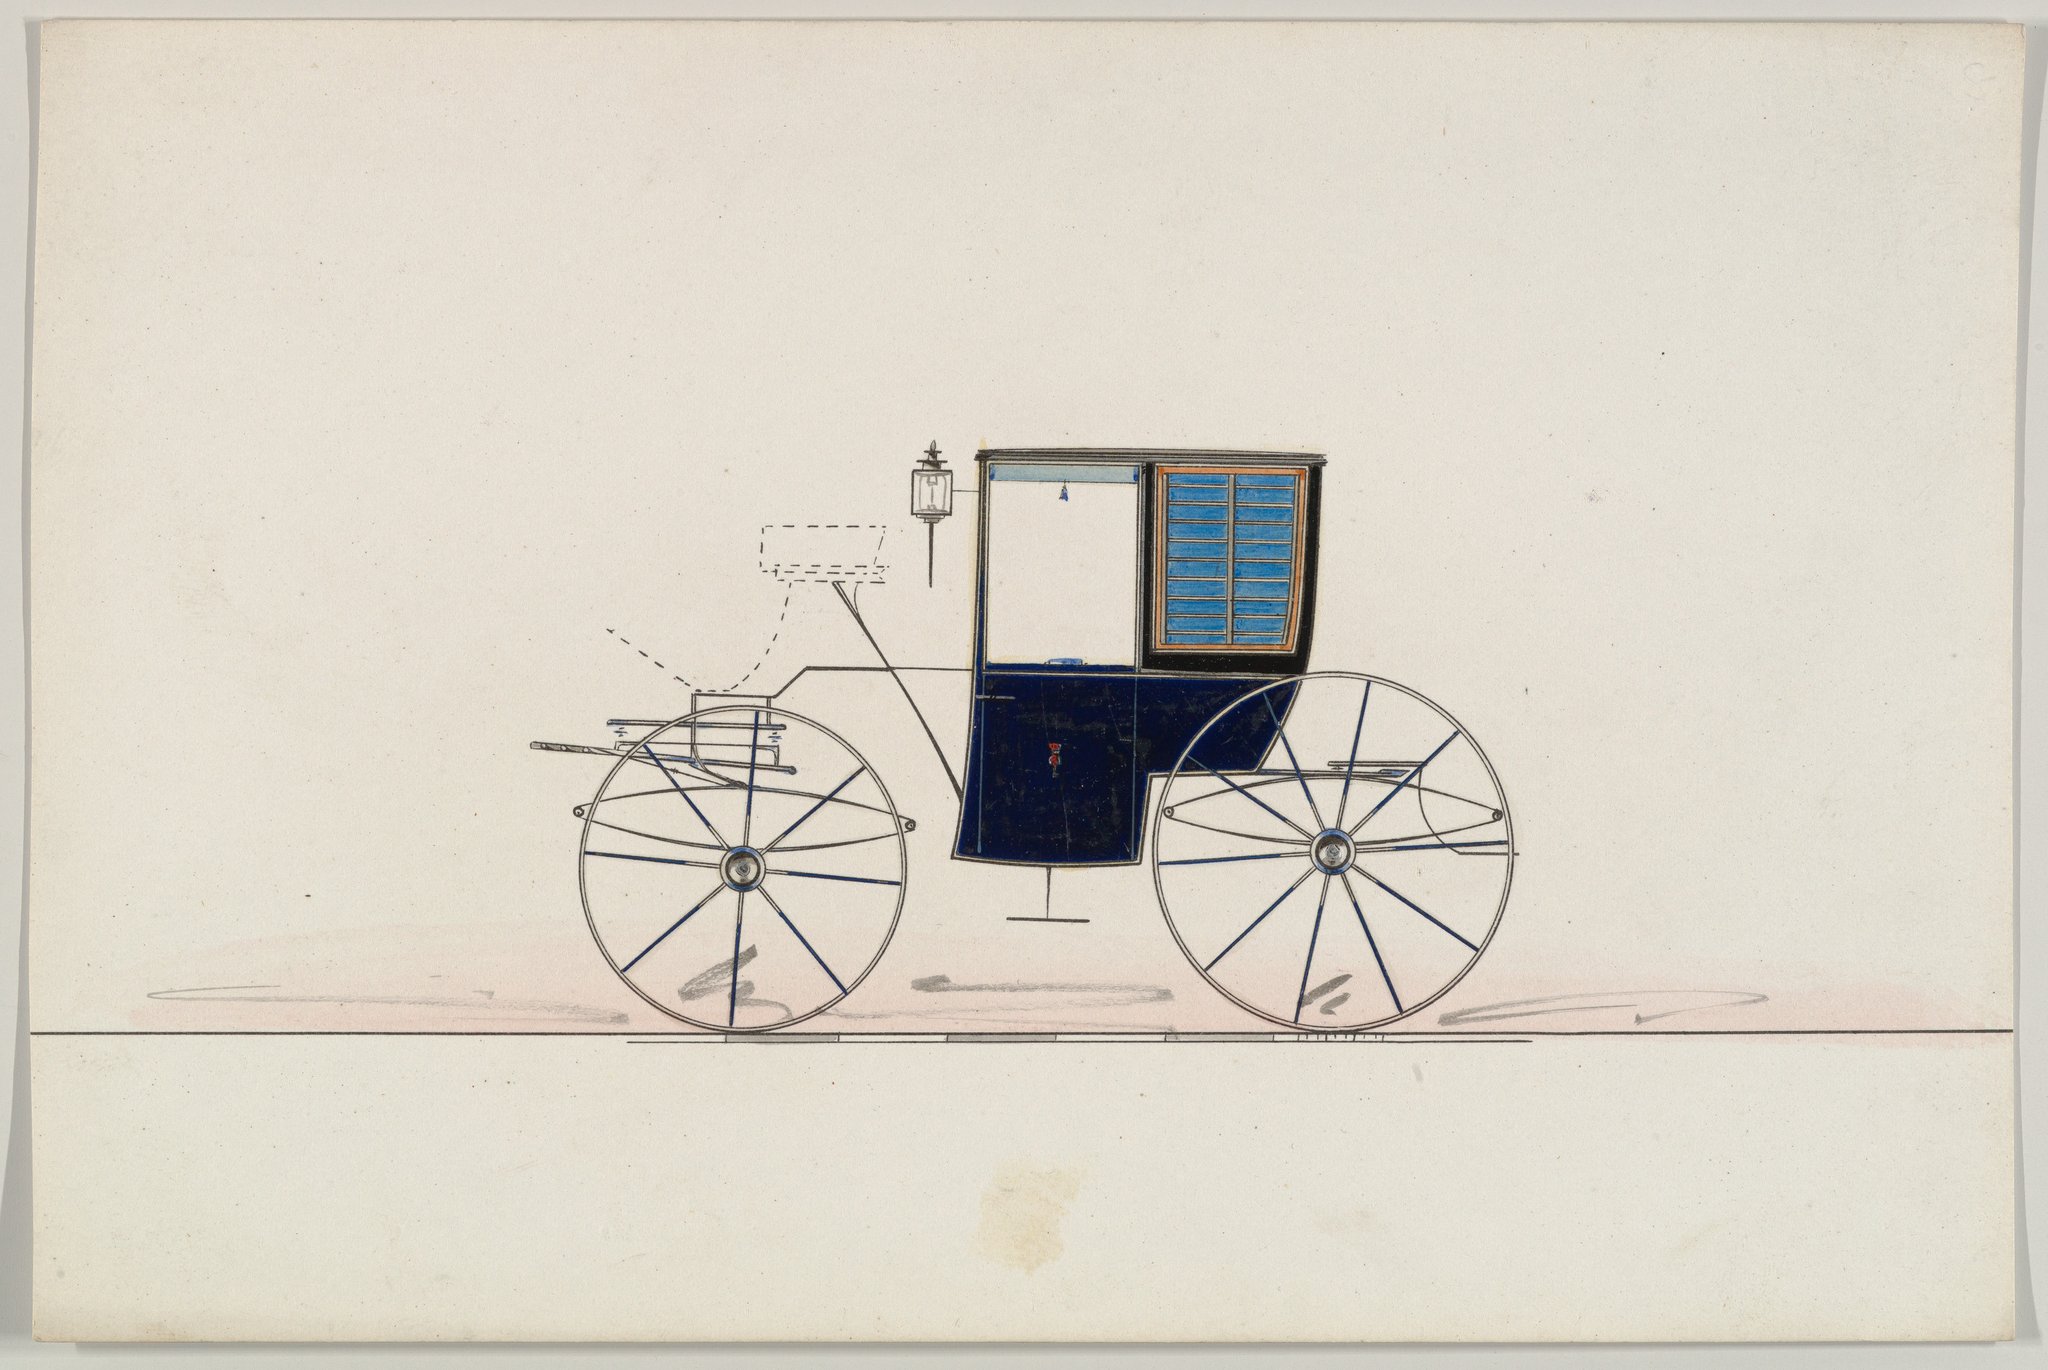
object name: drawing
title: Coupe (unnumbered)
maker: brewster & co.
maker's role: manufacturer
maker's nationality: american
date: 1850-1870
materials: gouache, gum arabic, ink, watercolor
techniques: pen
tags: carriages